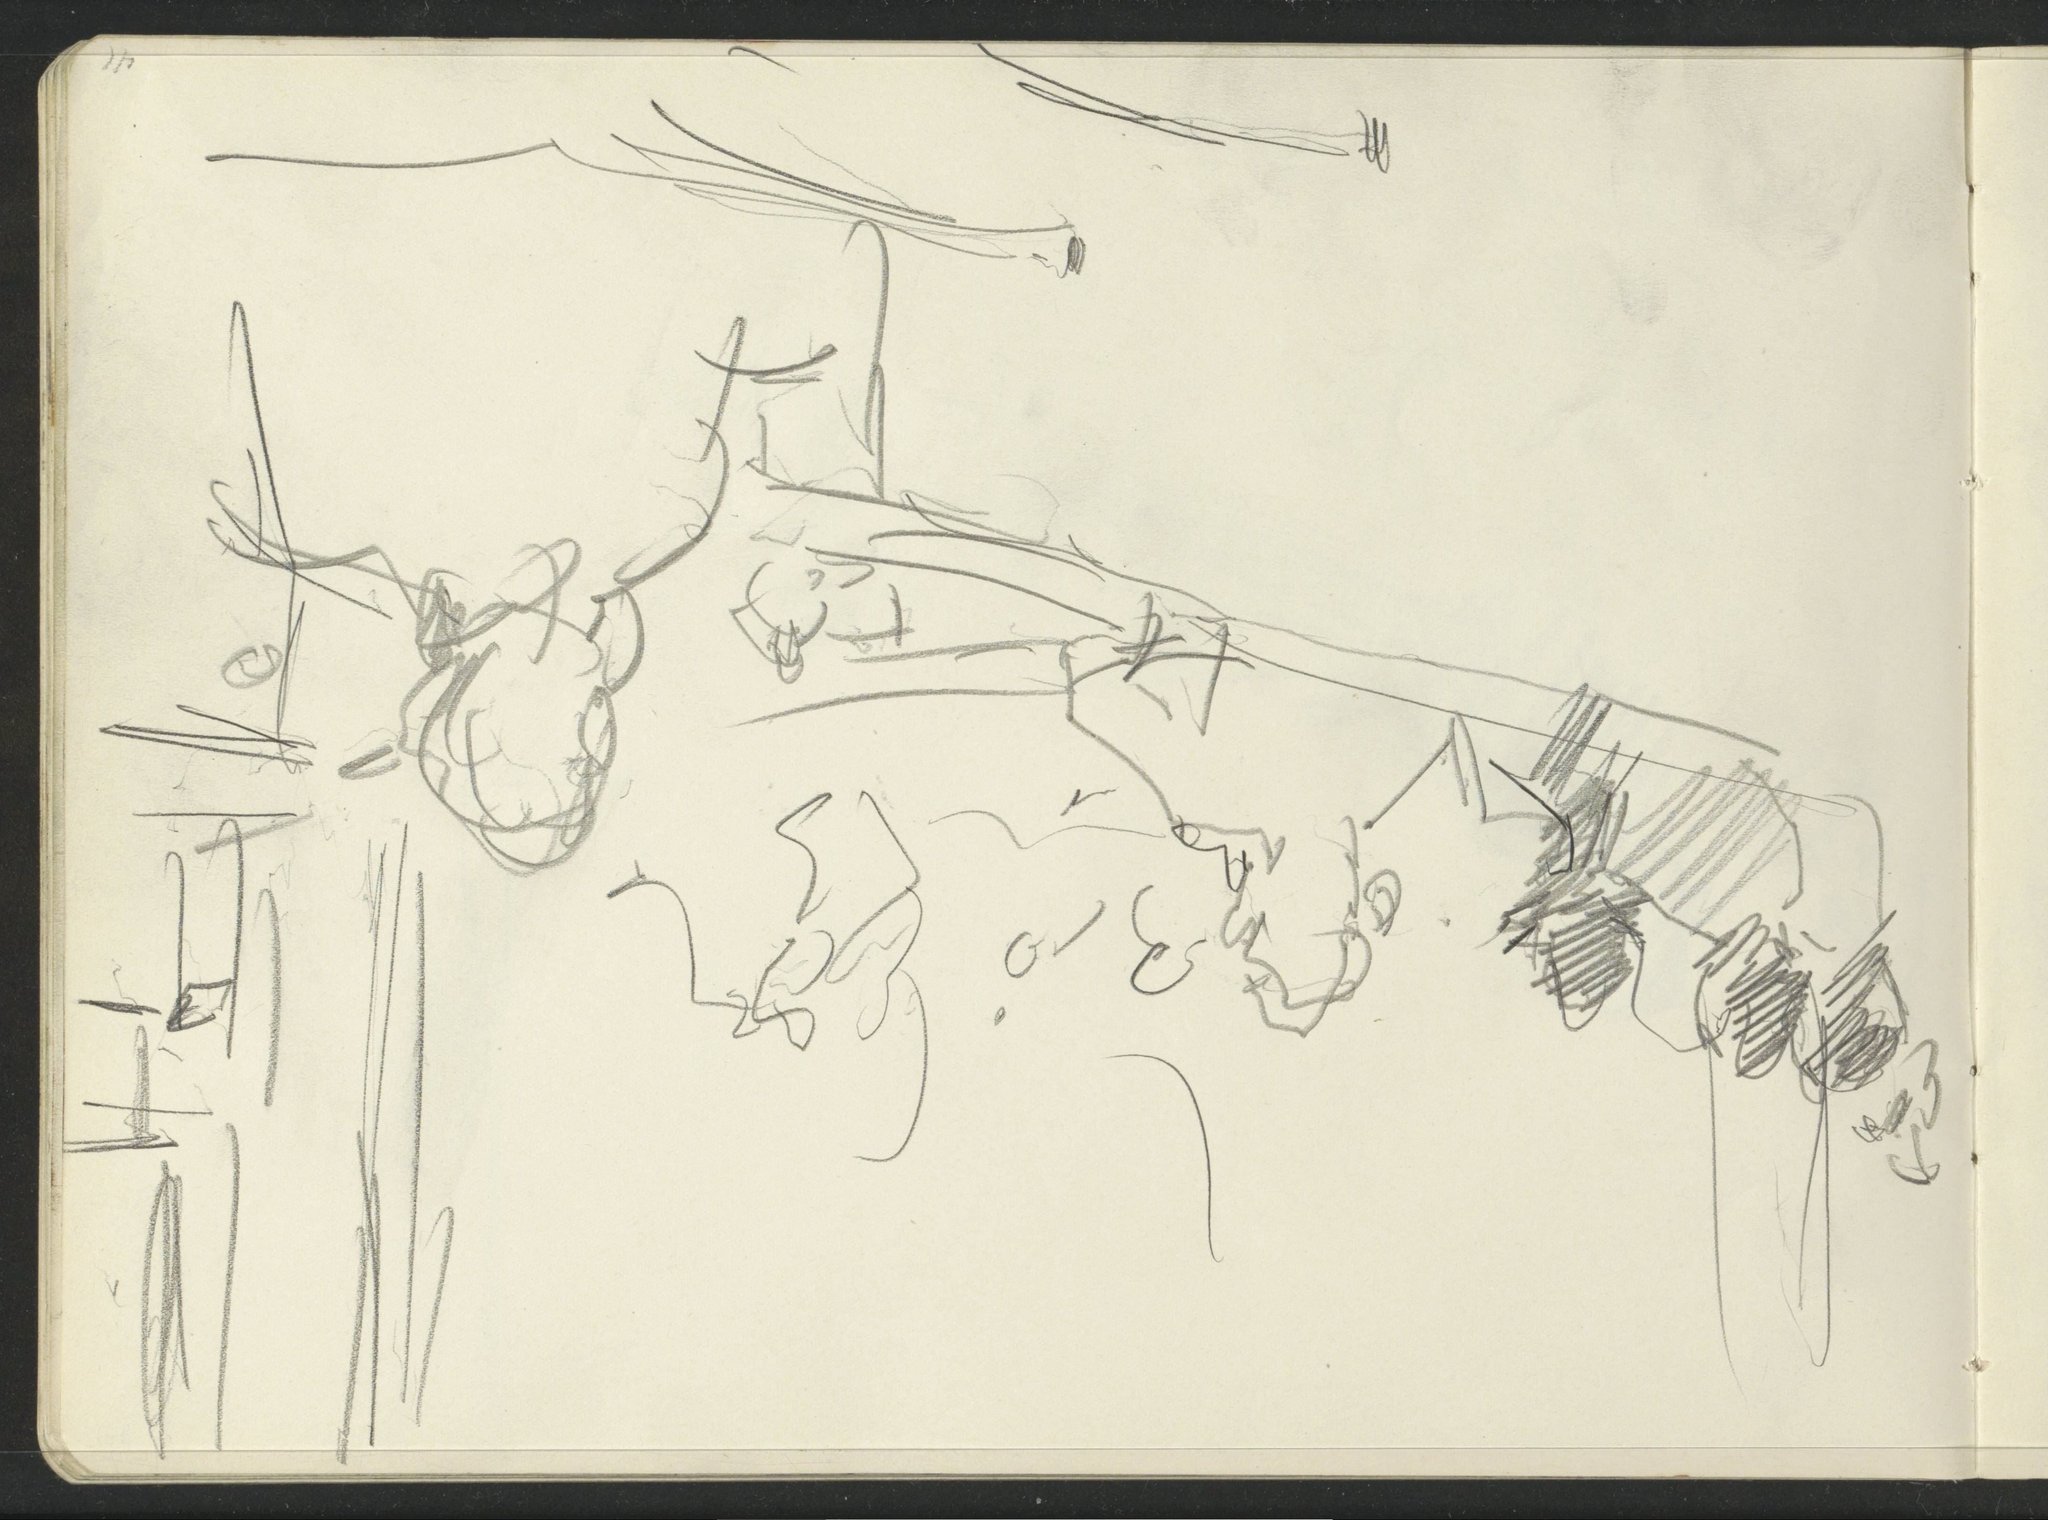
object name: sketchbook leaf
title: Toeschouwers in een theater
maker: isaac israels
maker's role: draughtsman, painter, print maker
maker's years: 1865-1934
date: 1915-1934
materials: paper, pencil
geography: the hague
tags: the audience ~ art performance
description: Blad 30 verso uit schetsboek XVIII met 35 bladen.